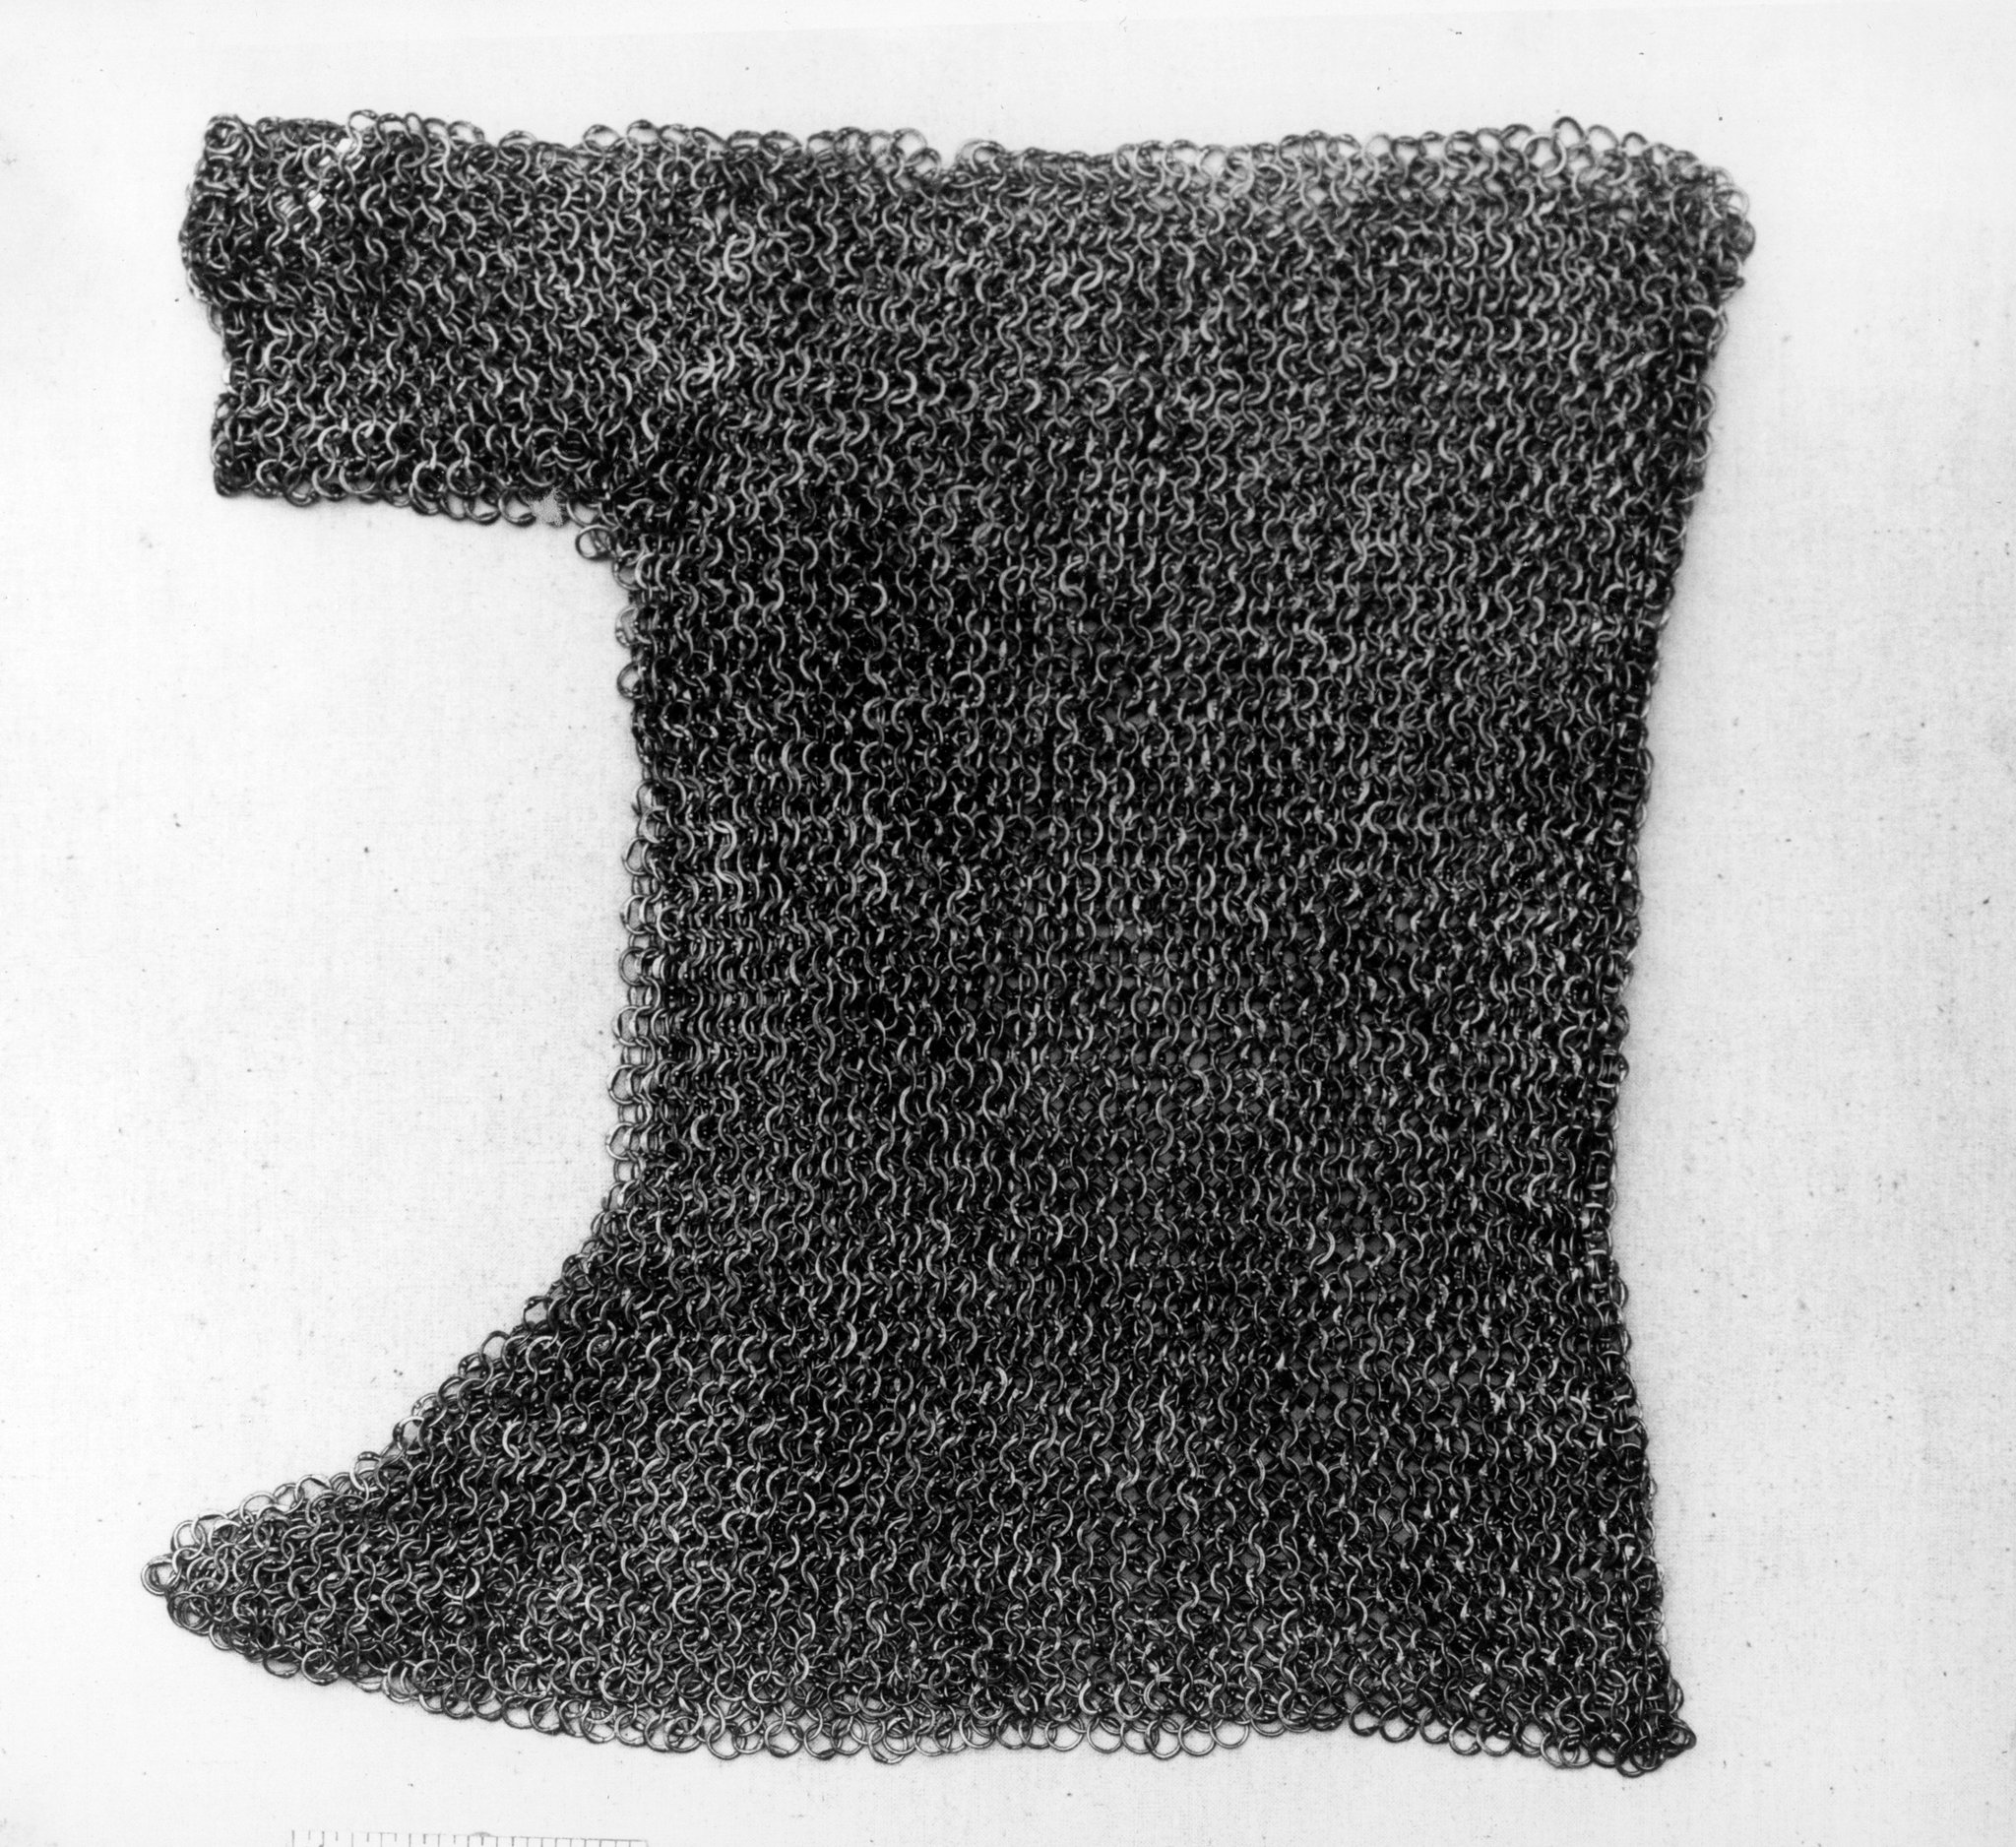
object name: mail neck defense for a horse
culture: german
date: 1501-1600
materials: steel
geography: germany